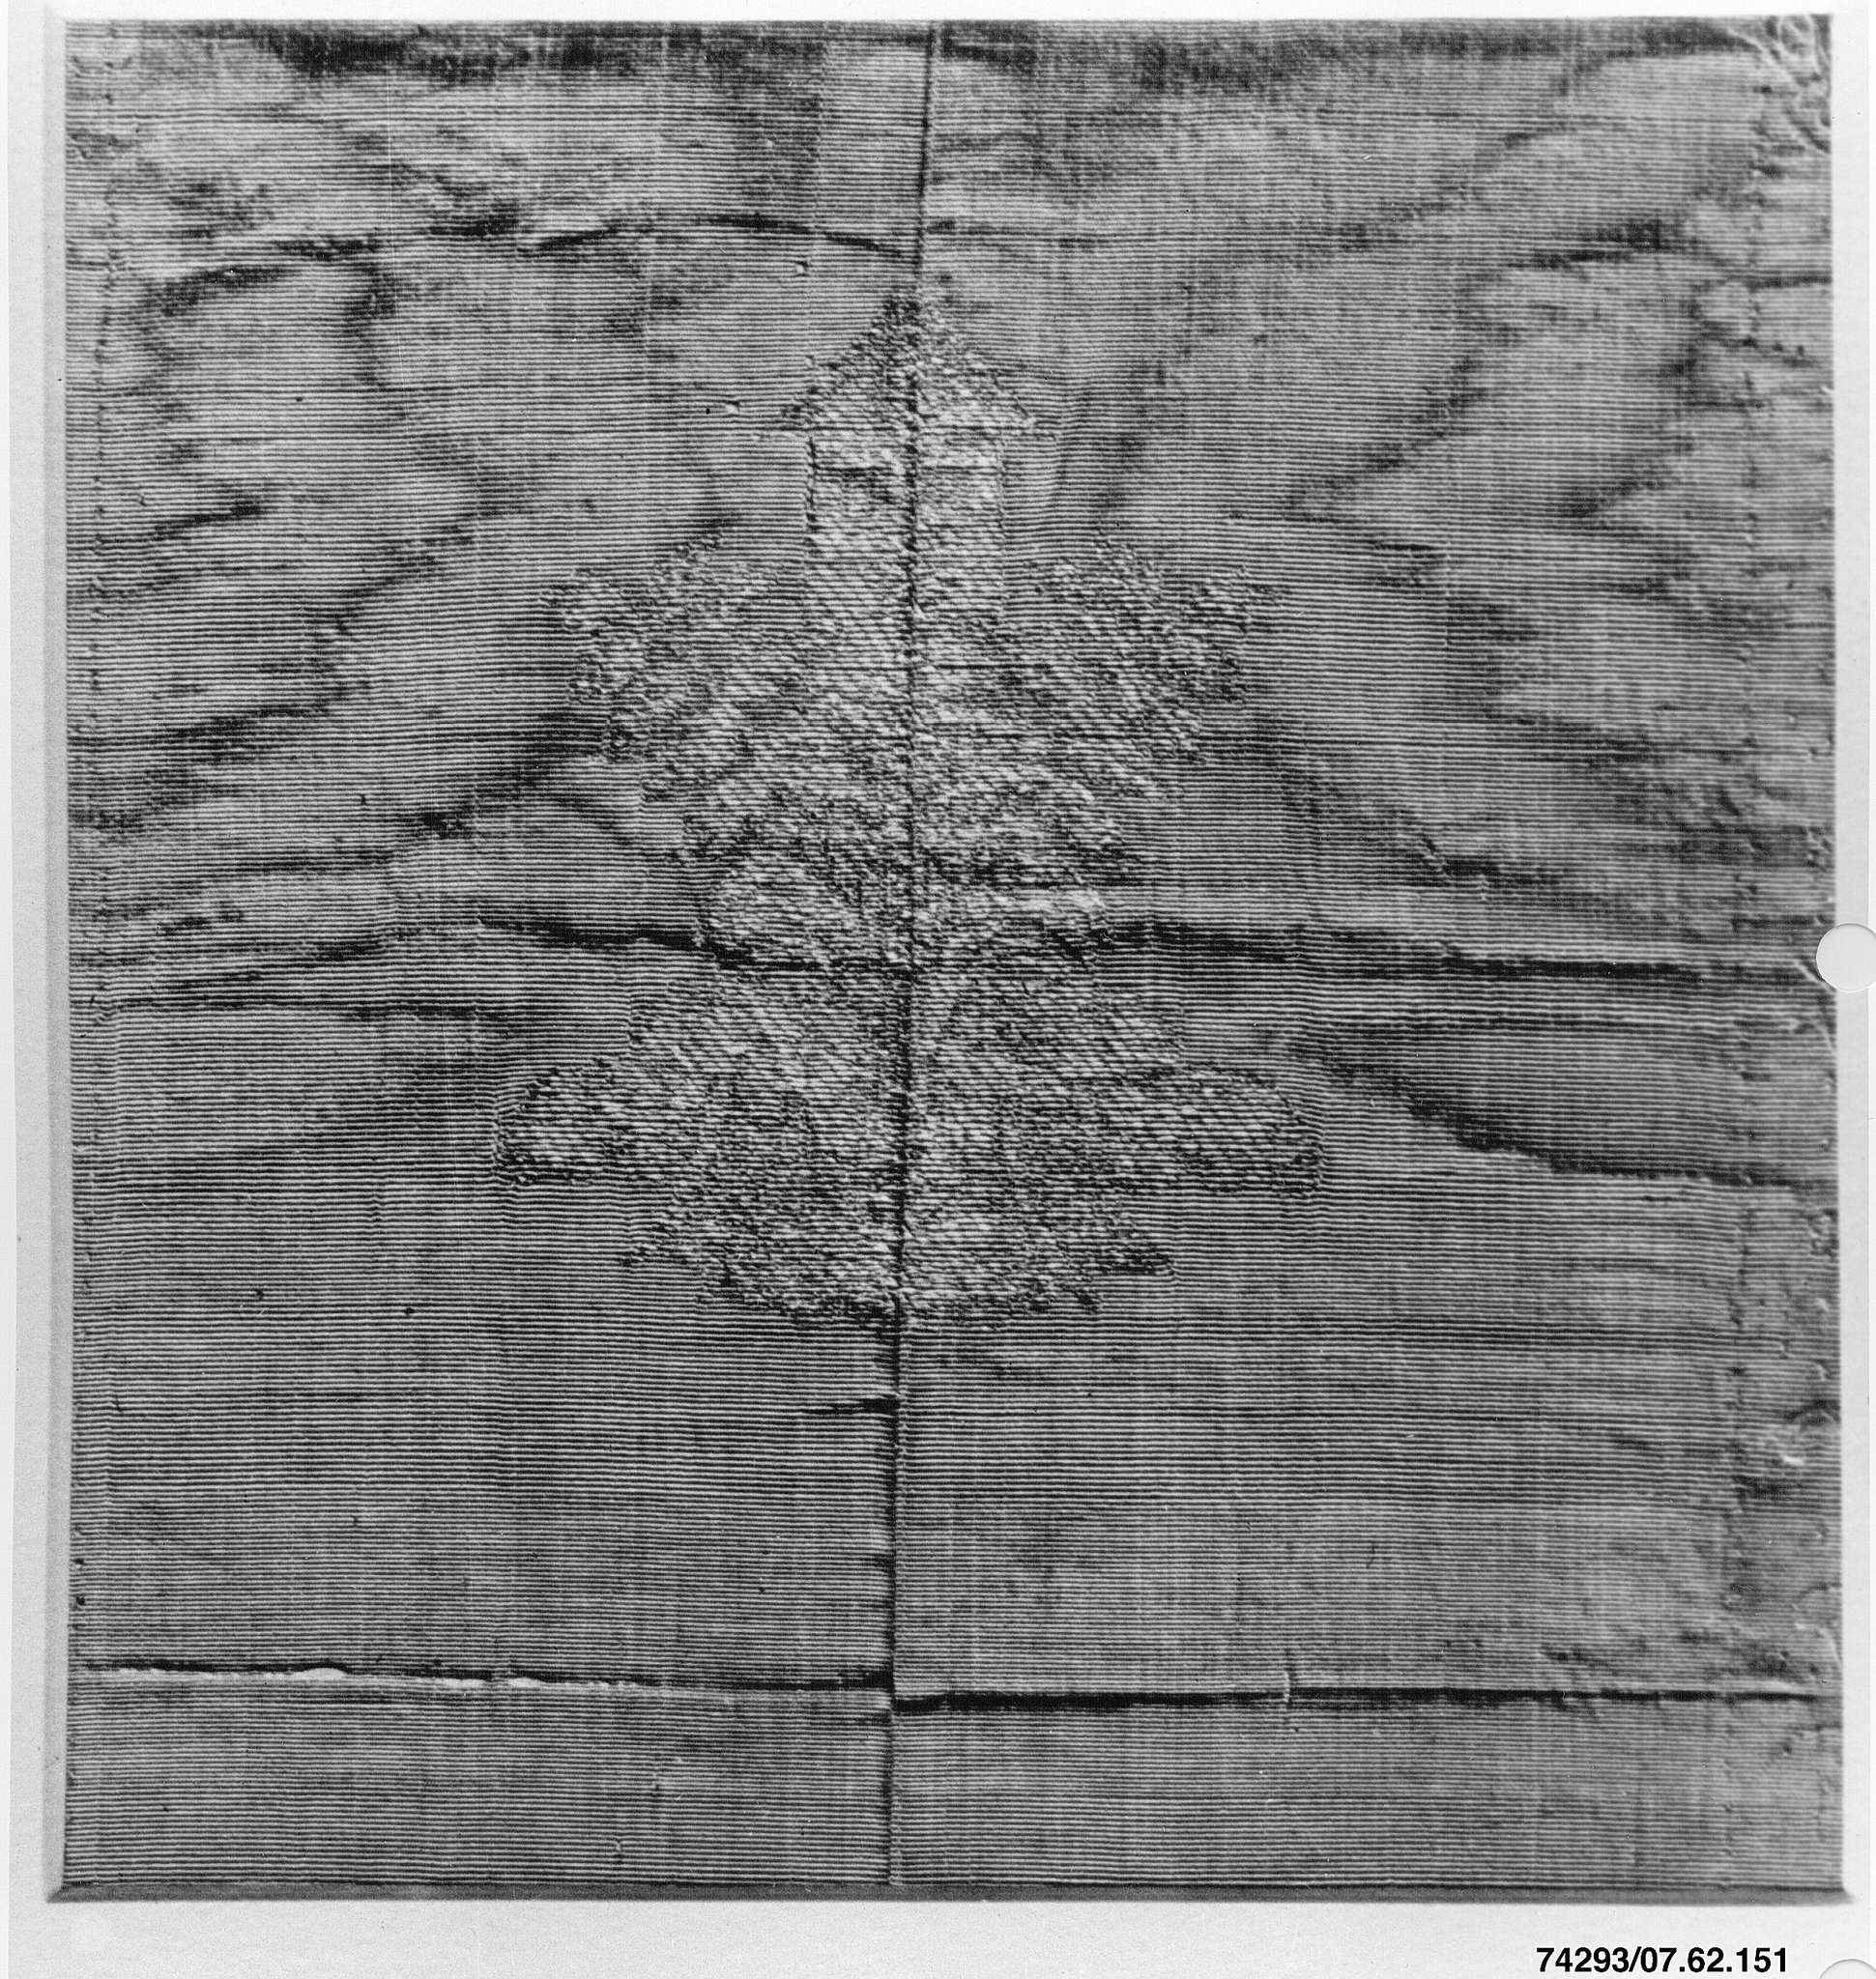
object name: piece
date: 1760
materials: metal thread, silk